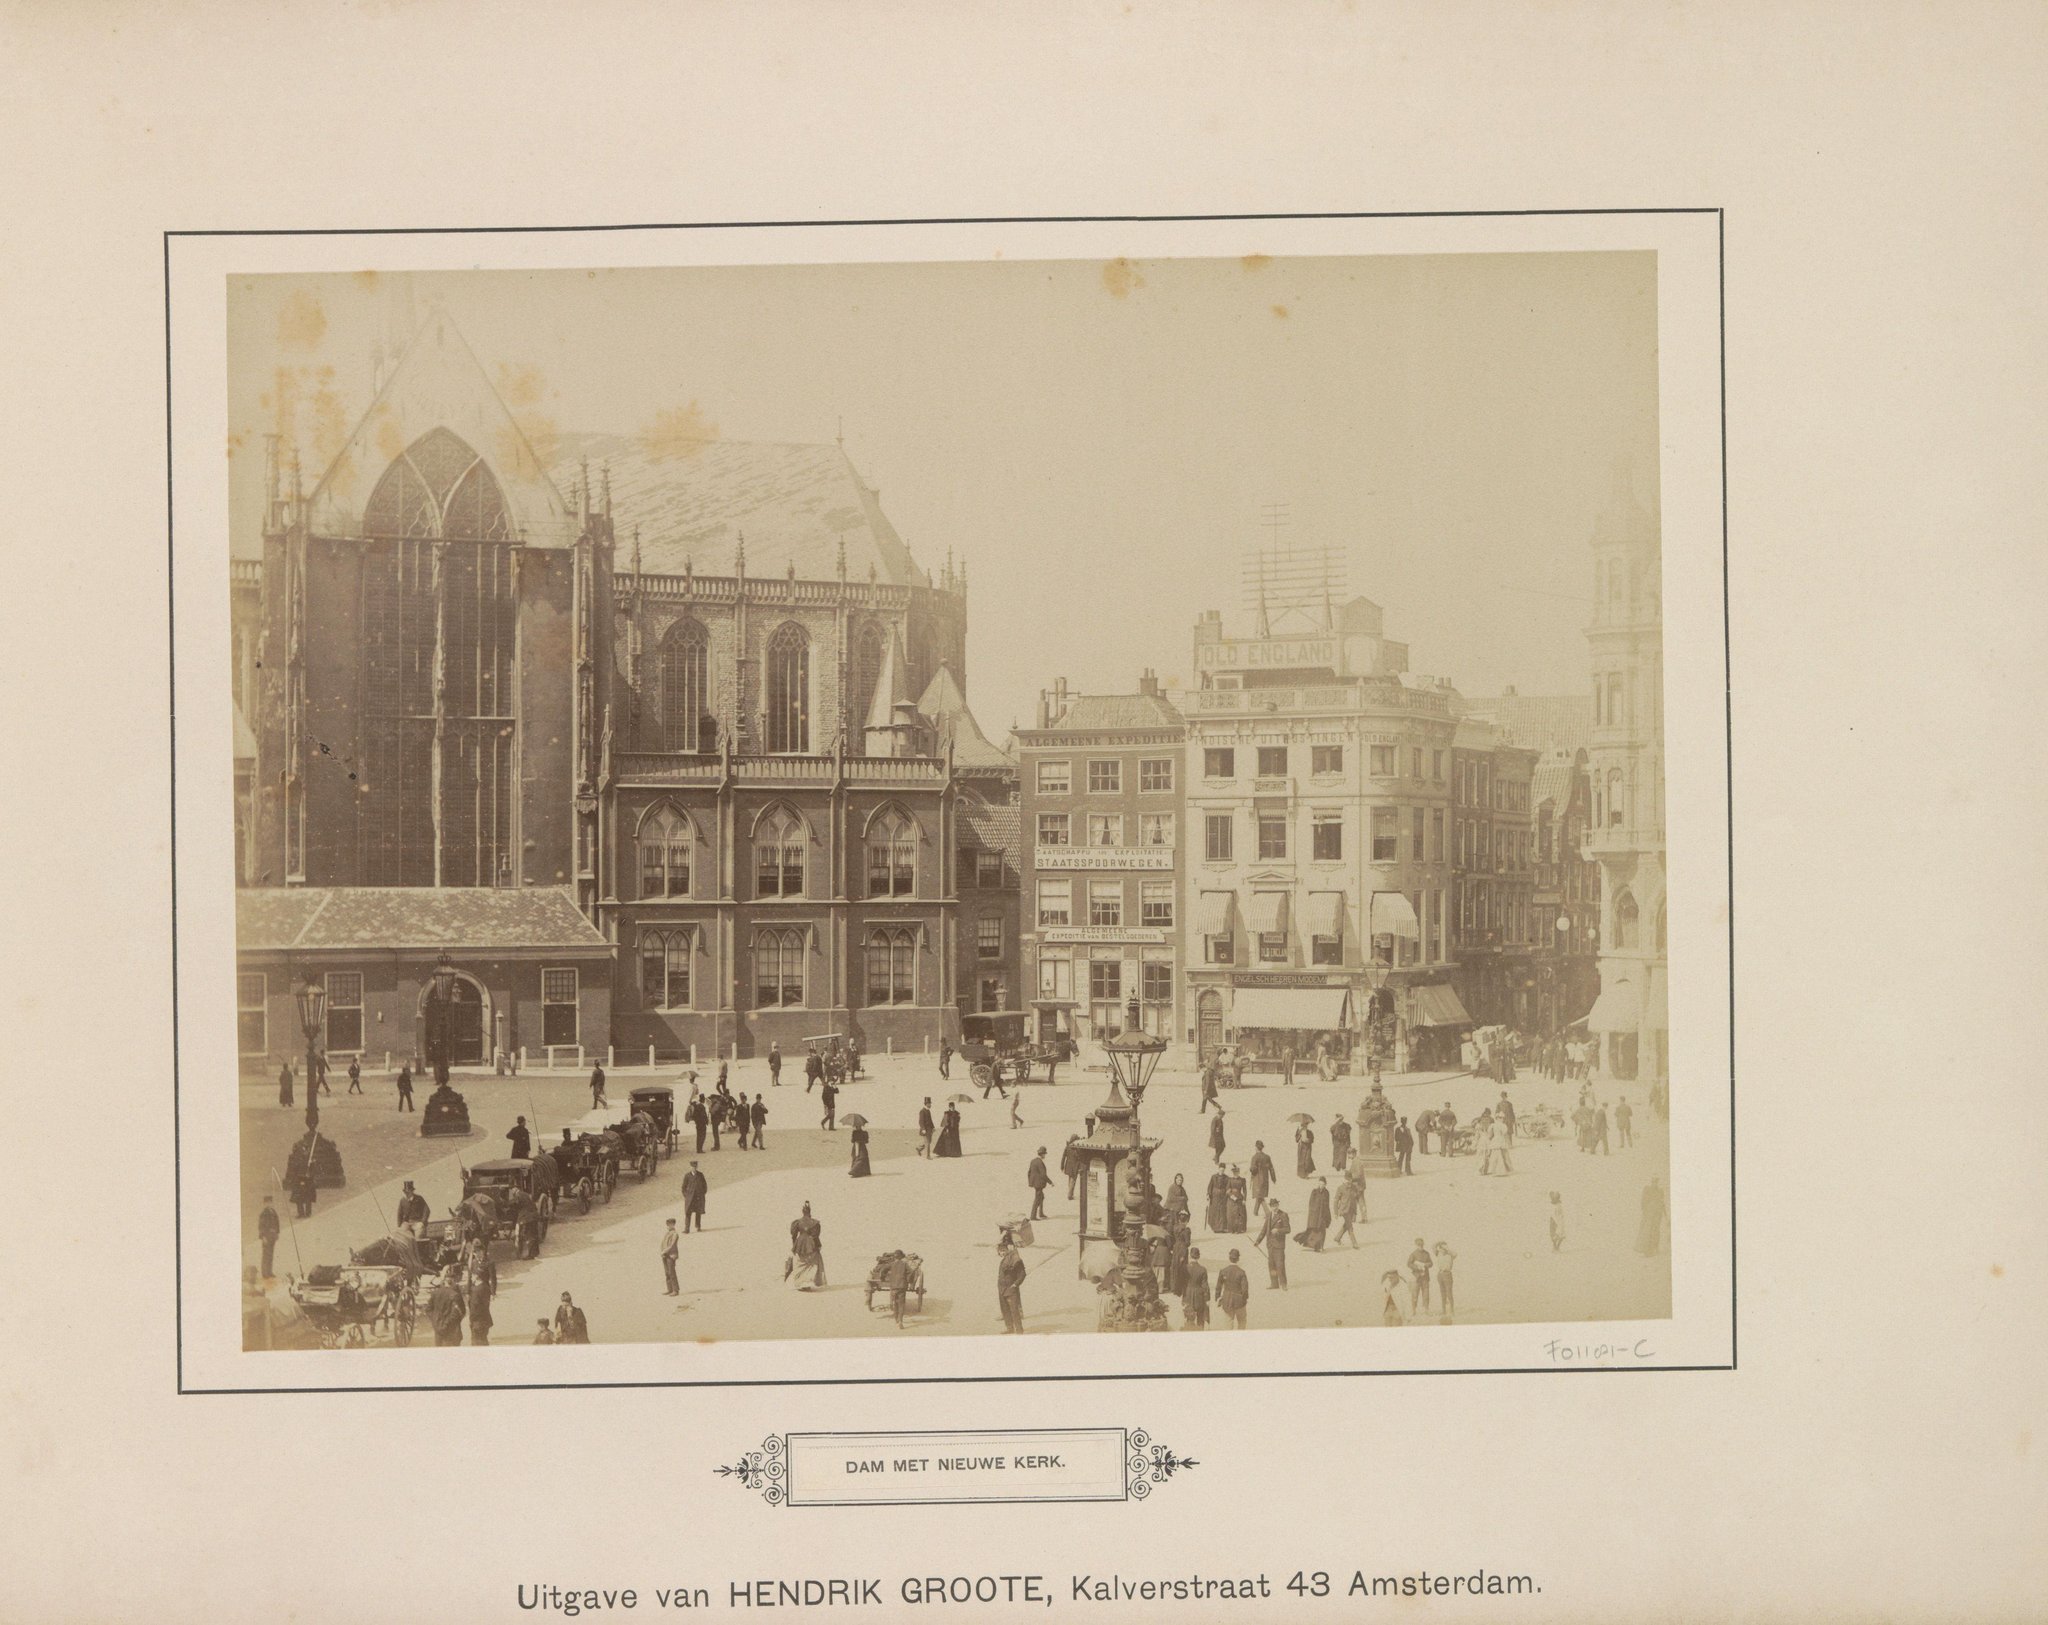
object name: photograph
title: Noordzijde van de Dam met de Nieuwe Kerk en de ingang van de Nieuwendijk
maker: Anonymous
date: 1880-1895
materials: photographic support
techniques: albumen print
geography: dam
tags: church (exterior), square, place, circus, etc. (+ city(-scape) with figures, staffage)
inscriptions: inscription: ‘Hendrik Groote Kalverstraat 43, Amsterdam. Photographic stores. Views from Holland. Photographs from ancient and modern dutch Paintings. Fines ans most complete Collection.’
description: Onderdeel van Fotoalbum met opnames van het centrum van Amsterdam en reclameteksten voor winkels en bedrijven.